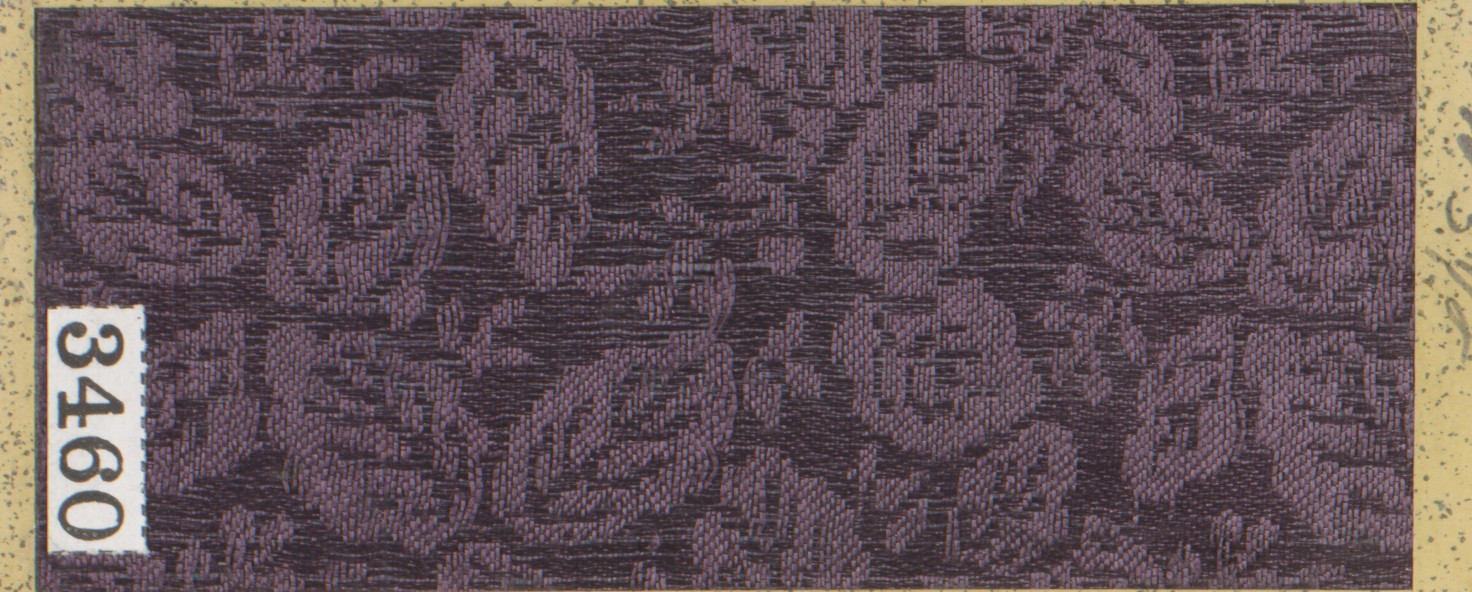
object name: sample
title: Textile Sample from Sample Book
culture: japanese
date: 1801-1900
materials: silk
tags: leaves